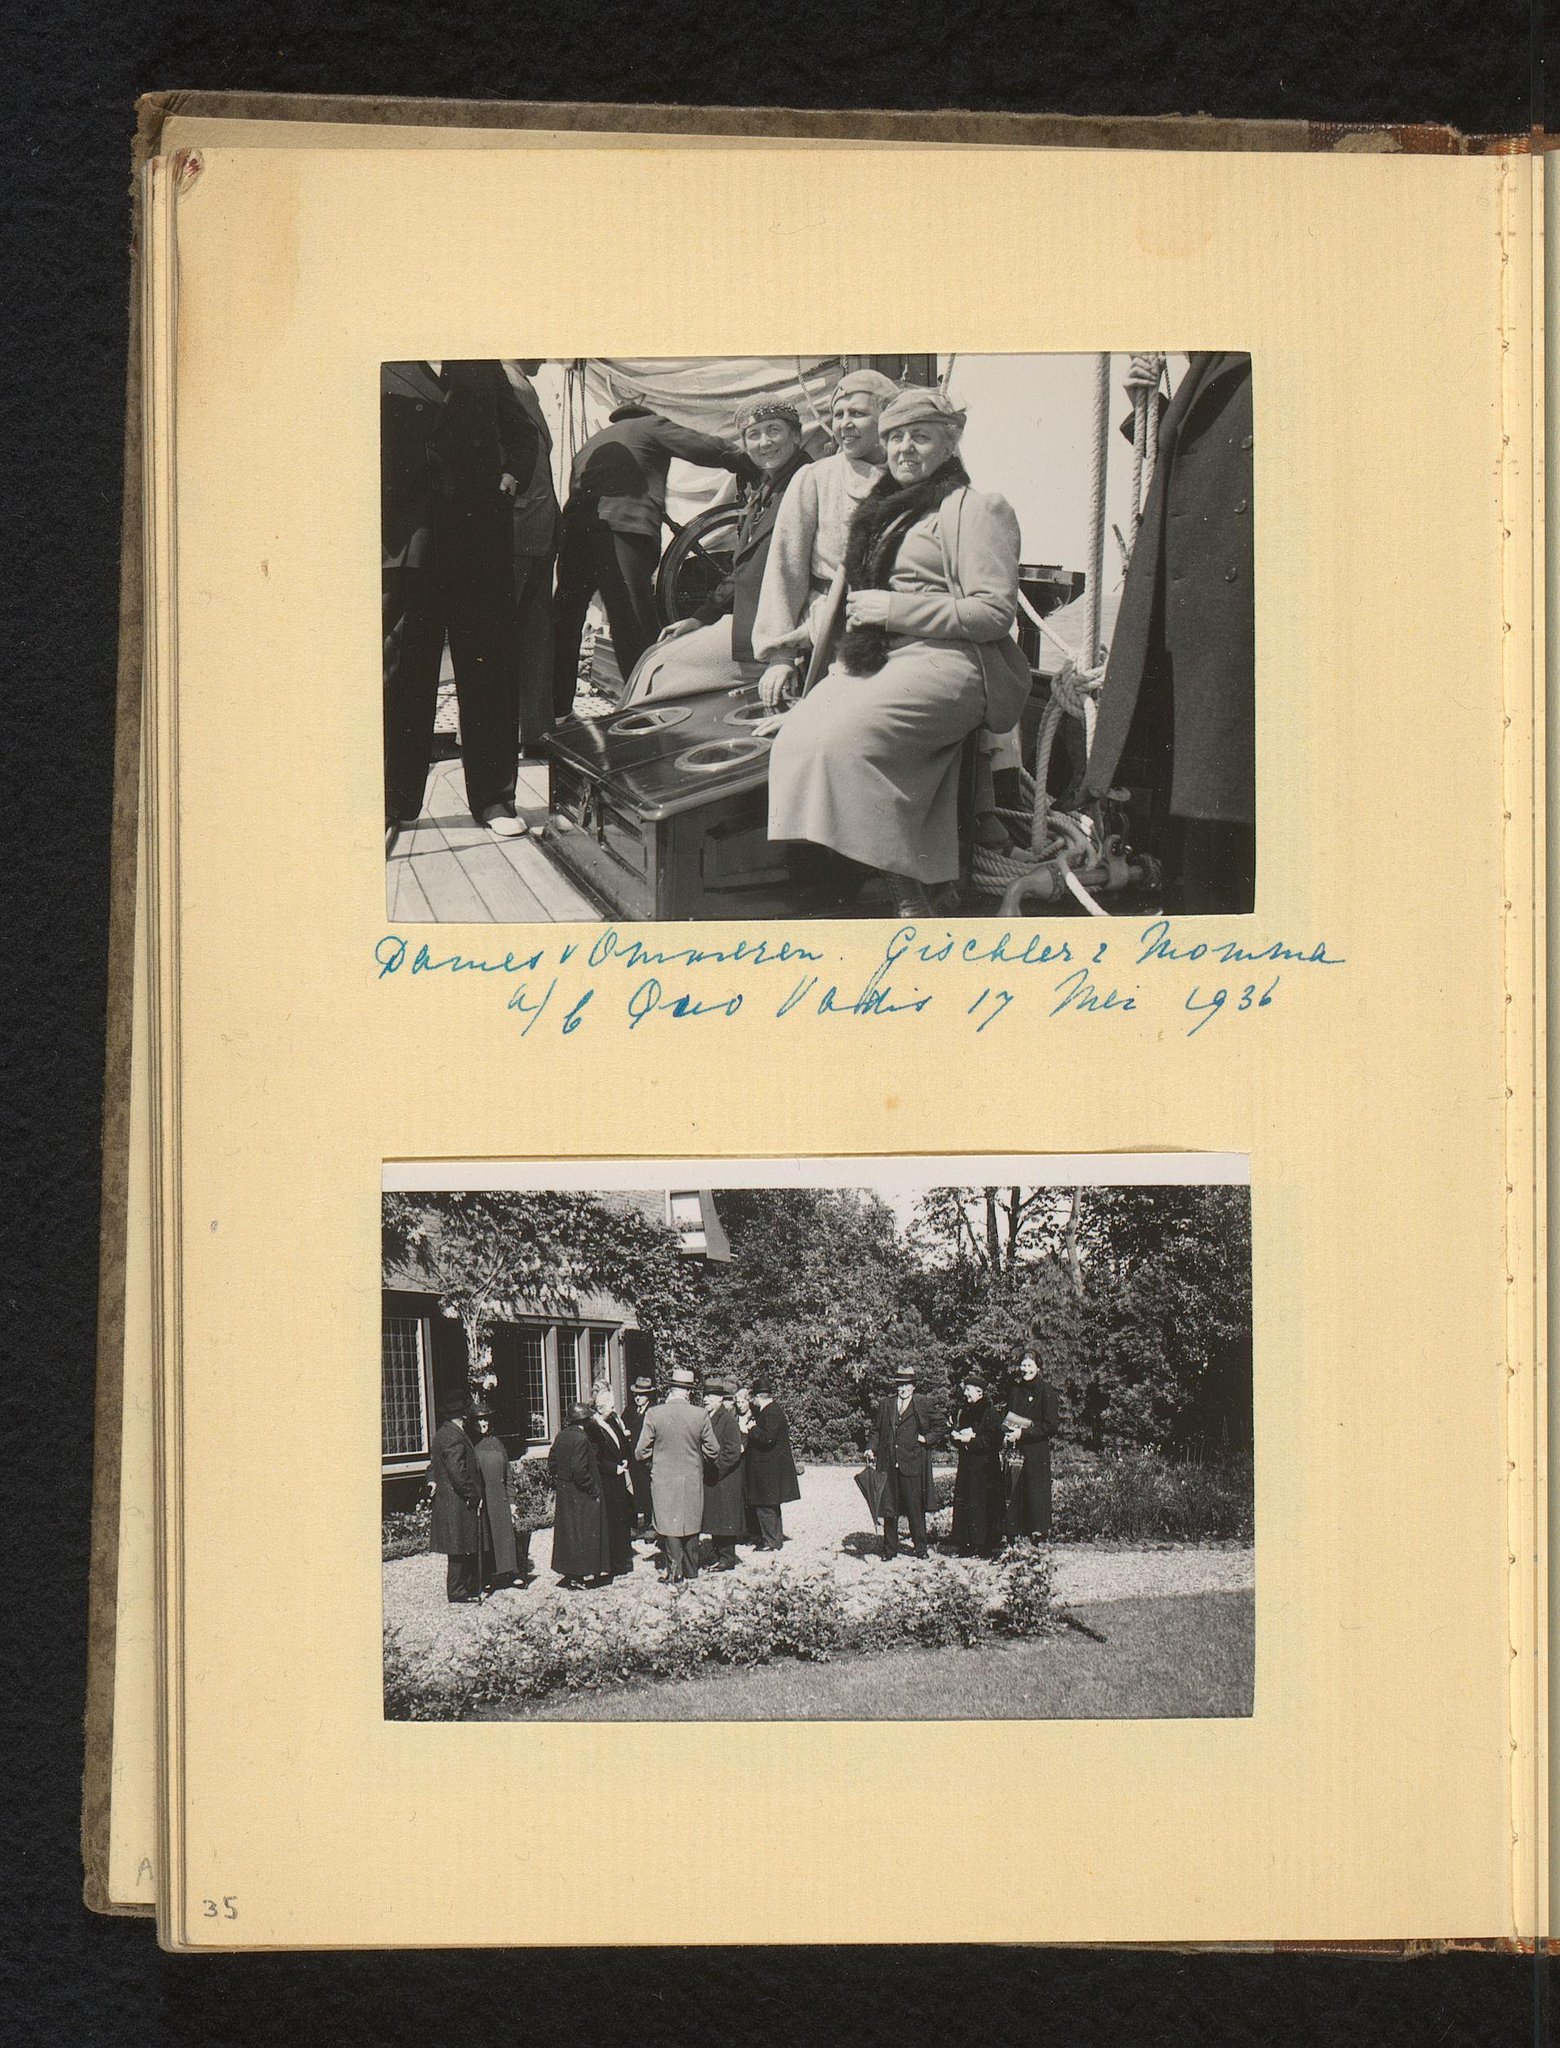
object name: photograph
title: Twee groepsportretten, van vrouwen op zeiljacht Quo Vadis en van professorengezelschap Vinculum Scientiarum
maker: Anonymous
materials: paper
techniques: gelatin silver print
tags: passengers ~ ship, professor, anonymous historical persons portrayed in a group, in a group-portrait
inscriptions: inscription: ‘Dames v Ommeren, Gischler & Momma/ a/b Quo Vadis 17 Mei 1936’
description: Deze foto's maken deel uit van een album.